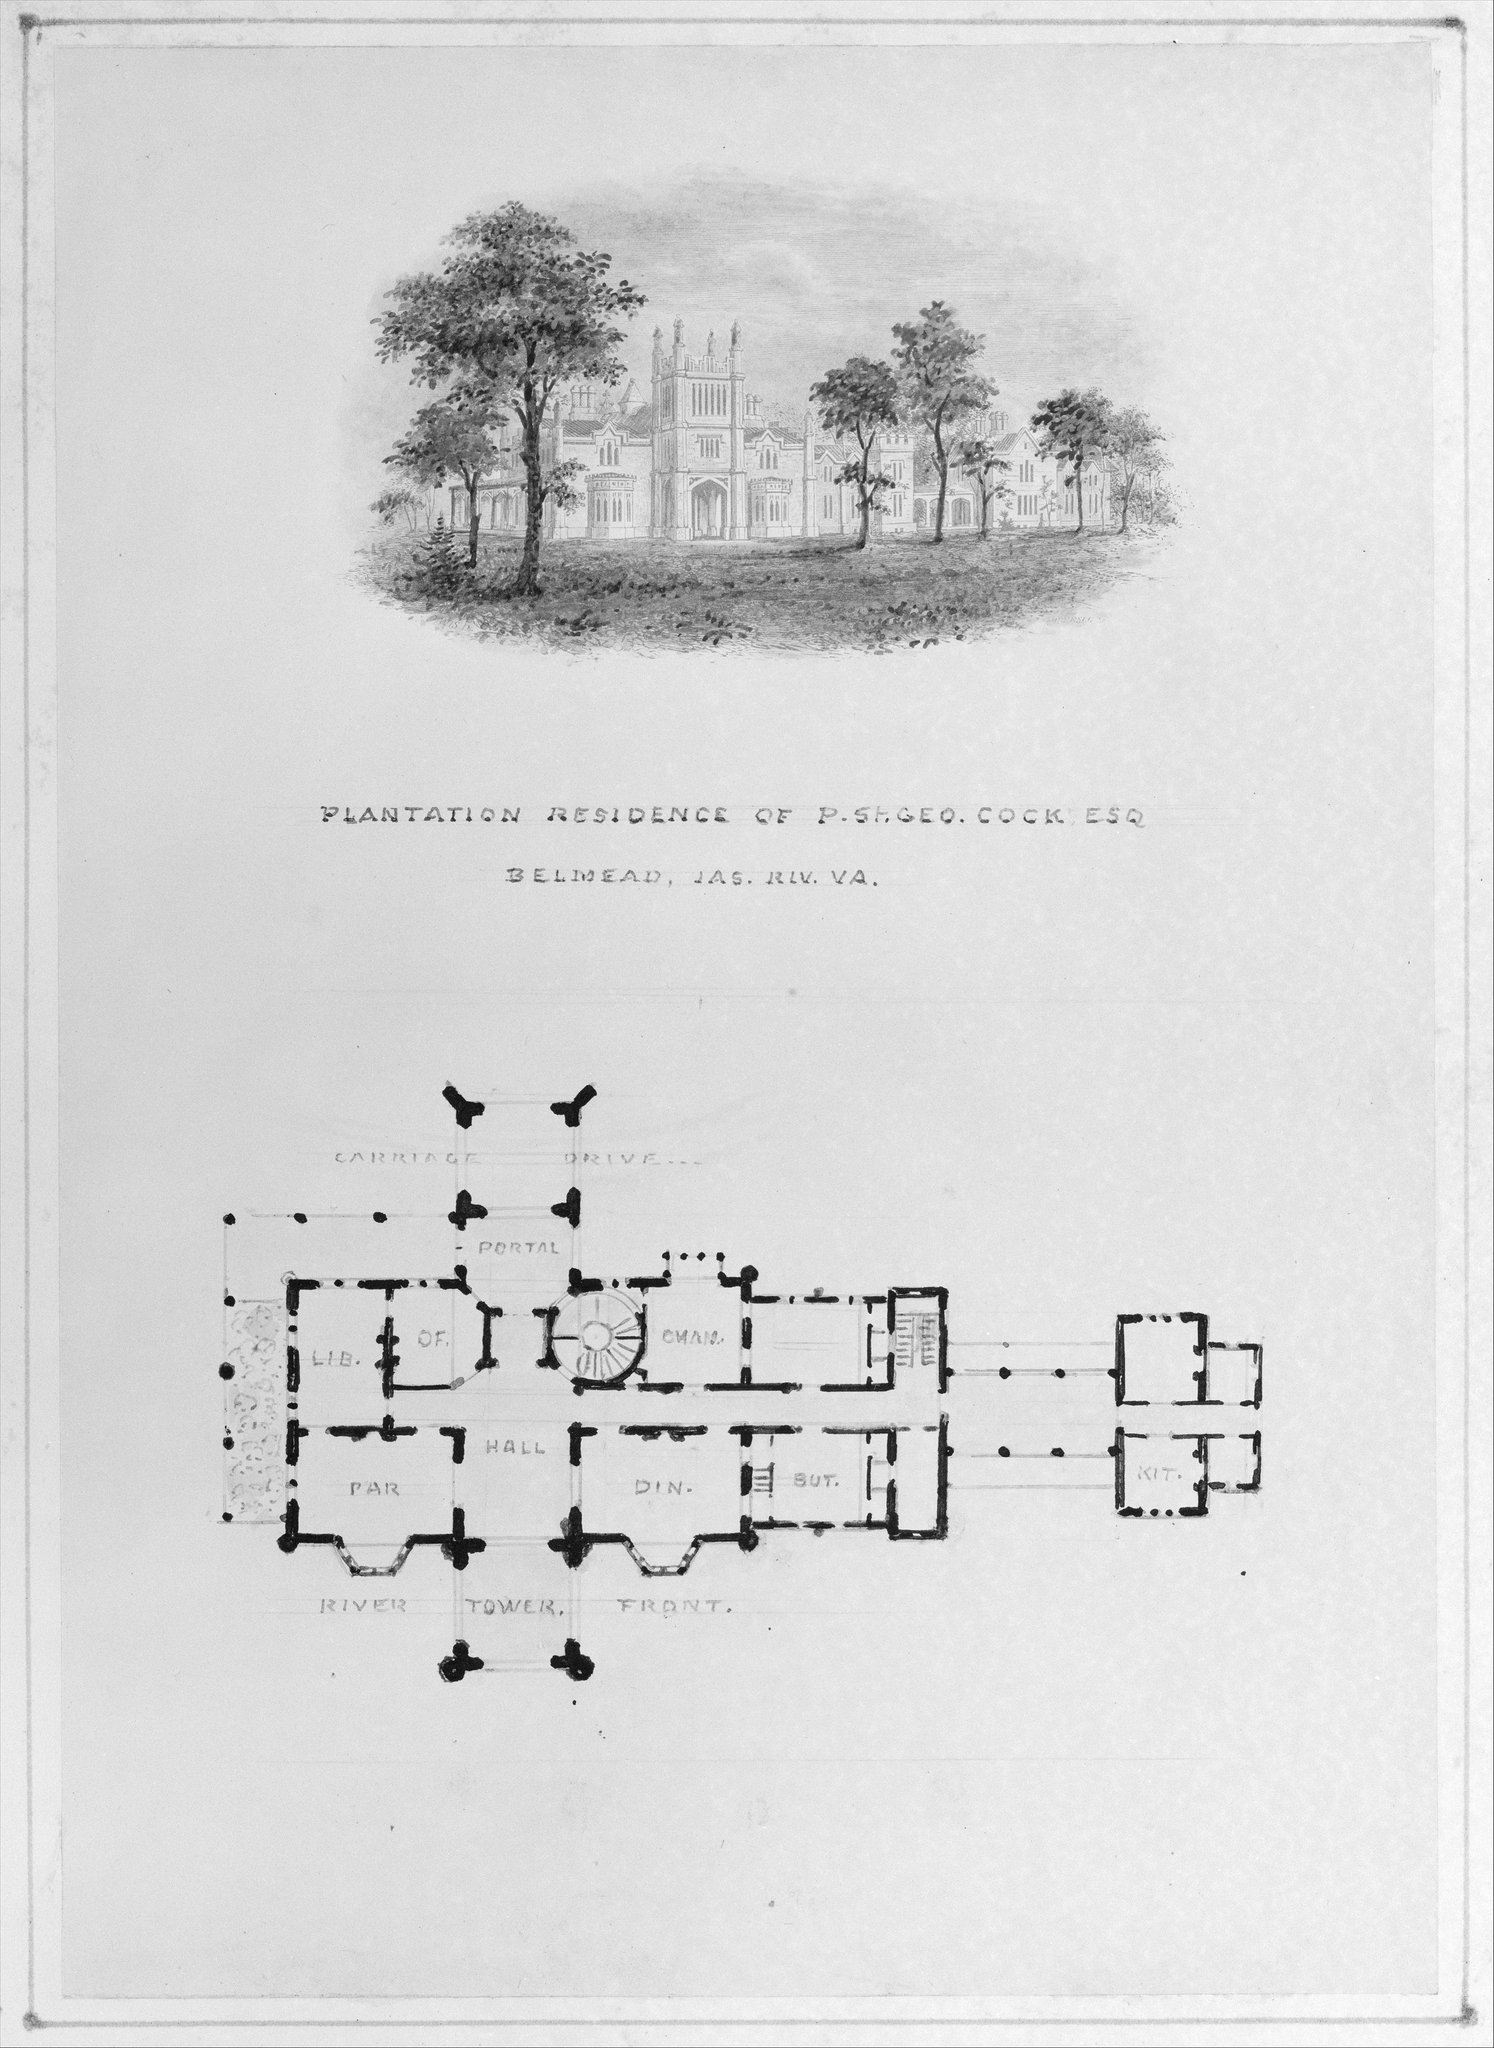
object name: print ornament architecture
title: Belmead, James River, Virginia (vignette of riverside elevation and plan)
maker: alexander jackson davis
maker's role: artist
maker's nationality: american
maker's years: 1803-1892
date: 1850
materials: ink, watercolor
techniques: pen, engraving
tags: architecture,buildings